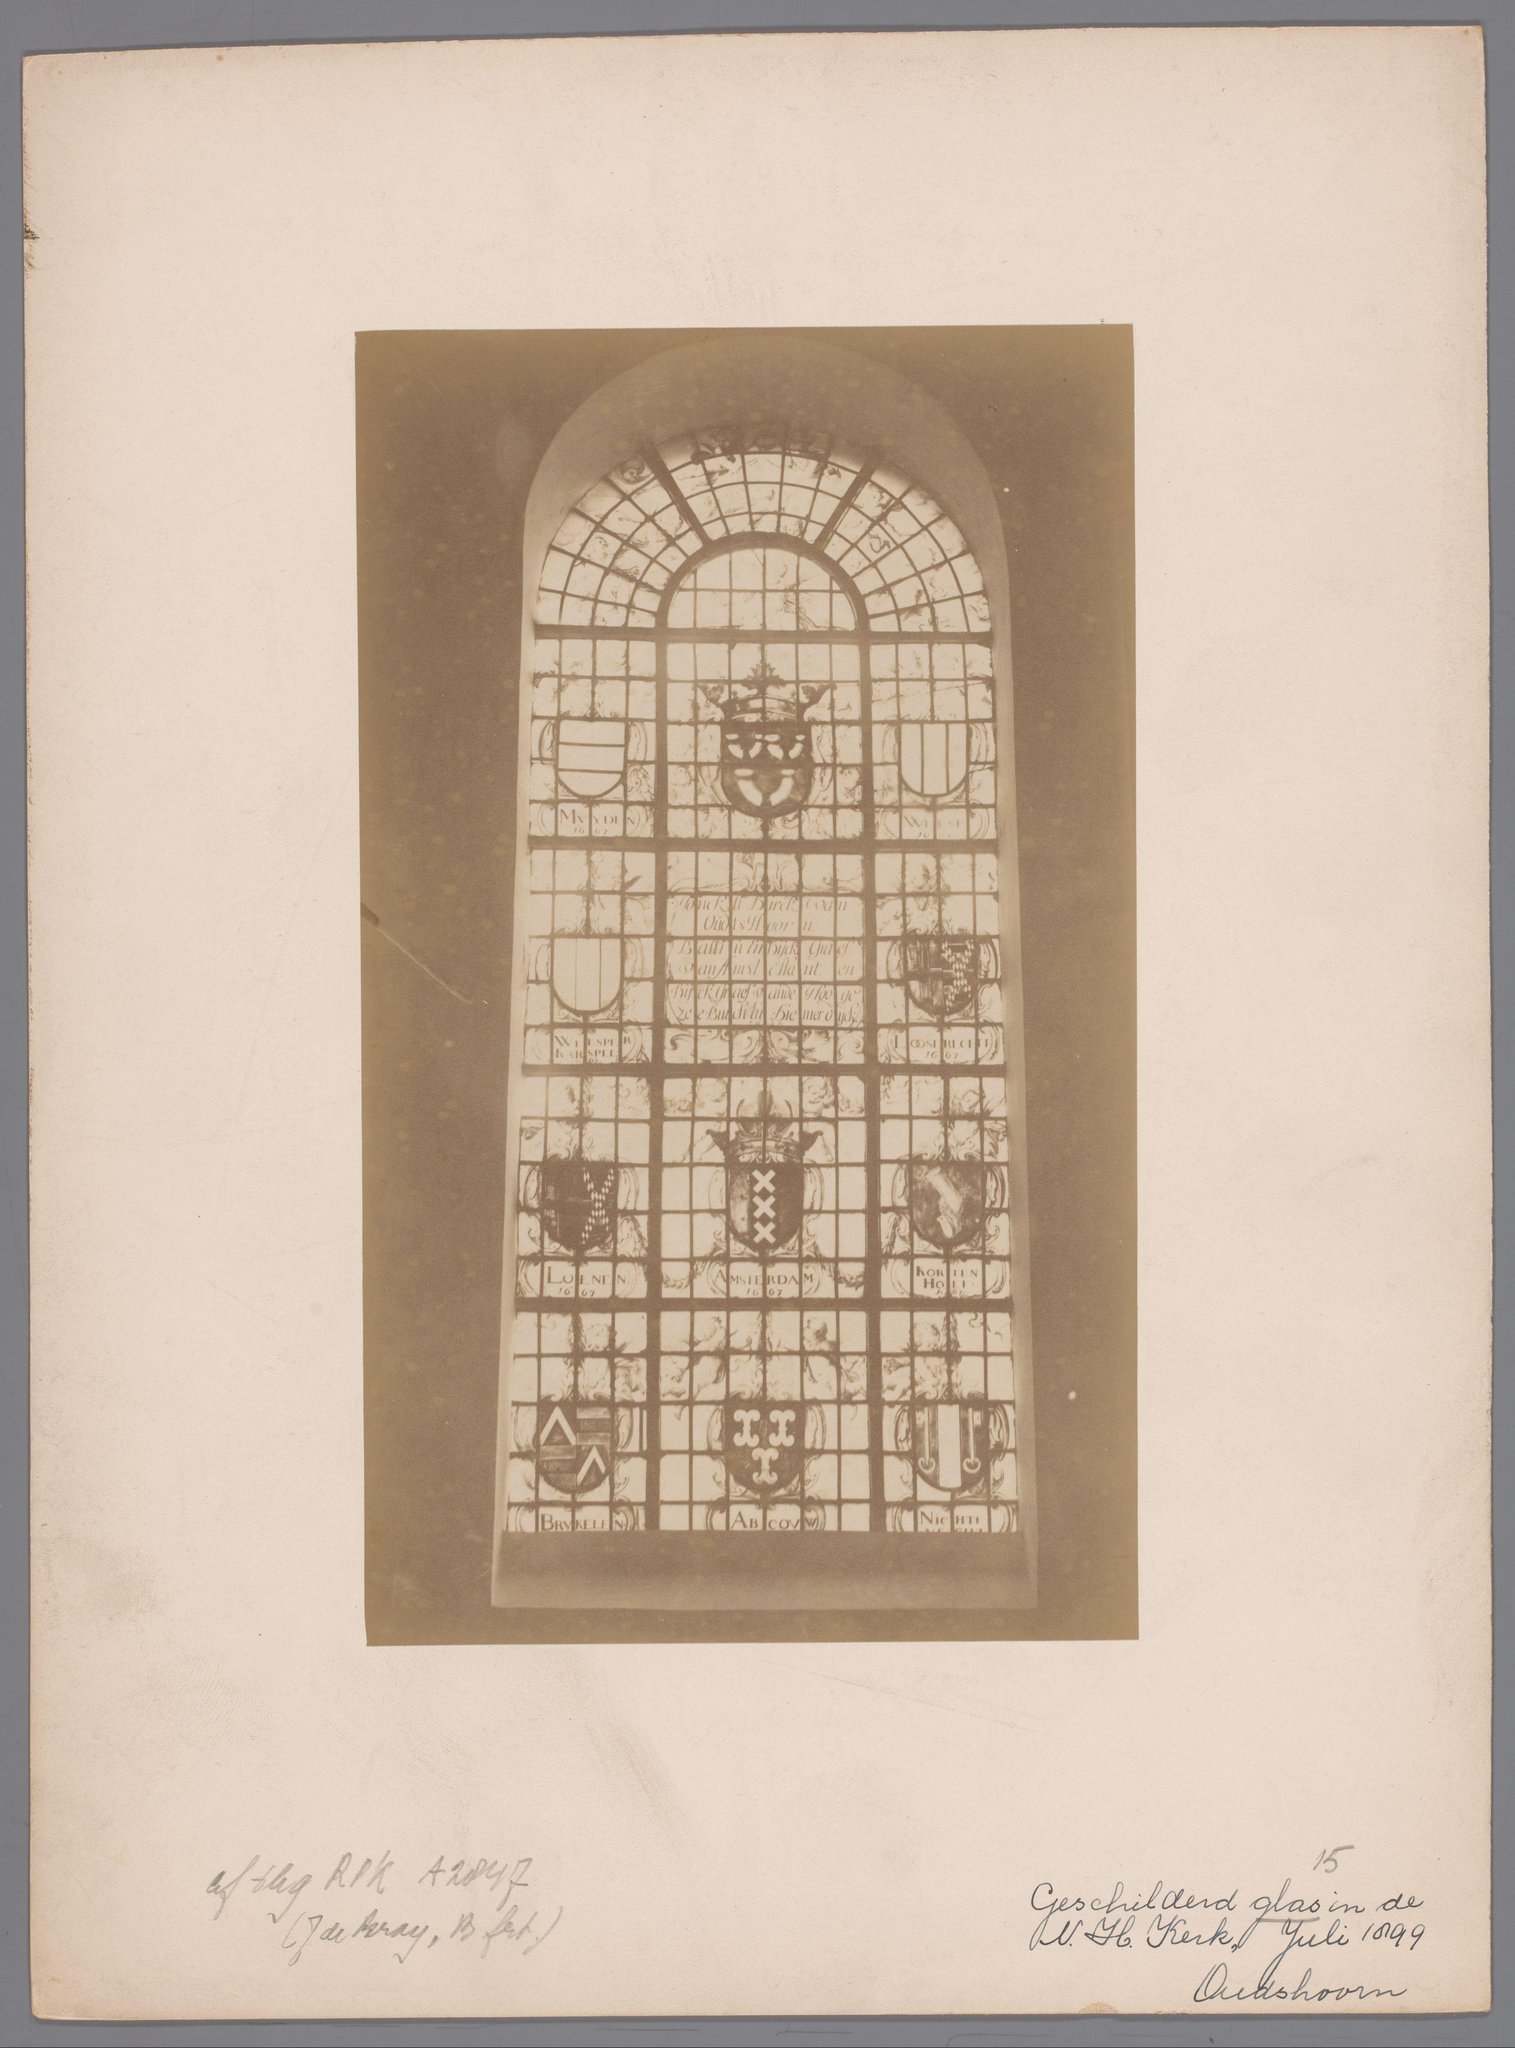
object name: photograph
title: Geschilderd raam in de Oudshoornse Kerk te Oudshoorn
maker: anoniem (monumentenzorg)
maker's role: fotograaf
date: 1899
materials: cardboard, photographic support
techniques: albumen print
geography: oudshoorn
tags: church-window, e.g. rose-window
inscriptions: annotation: ‘[...] RPK A2847 [...]’, annotation: ‘Geschilderd glas in de Ned Herv kerk te Oudshoorn (Z.H.)/ Juli 1899’, annotation: ‘Geschilderd glas 15 in de N.H. Kerk Juli 1899/ Oudshoorn’